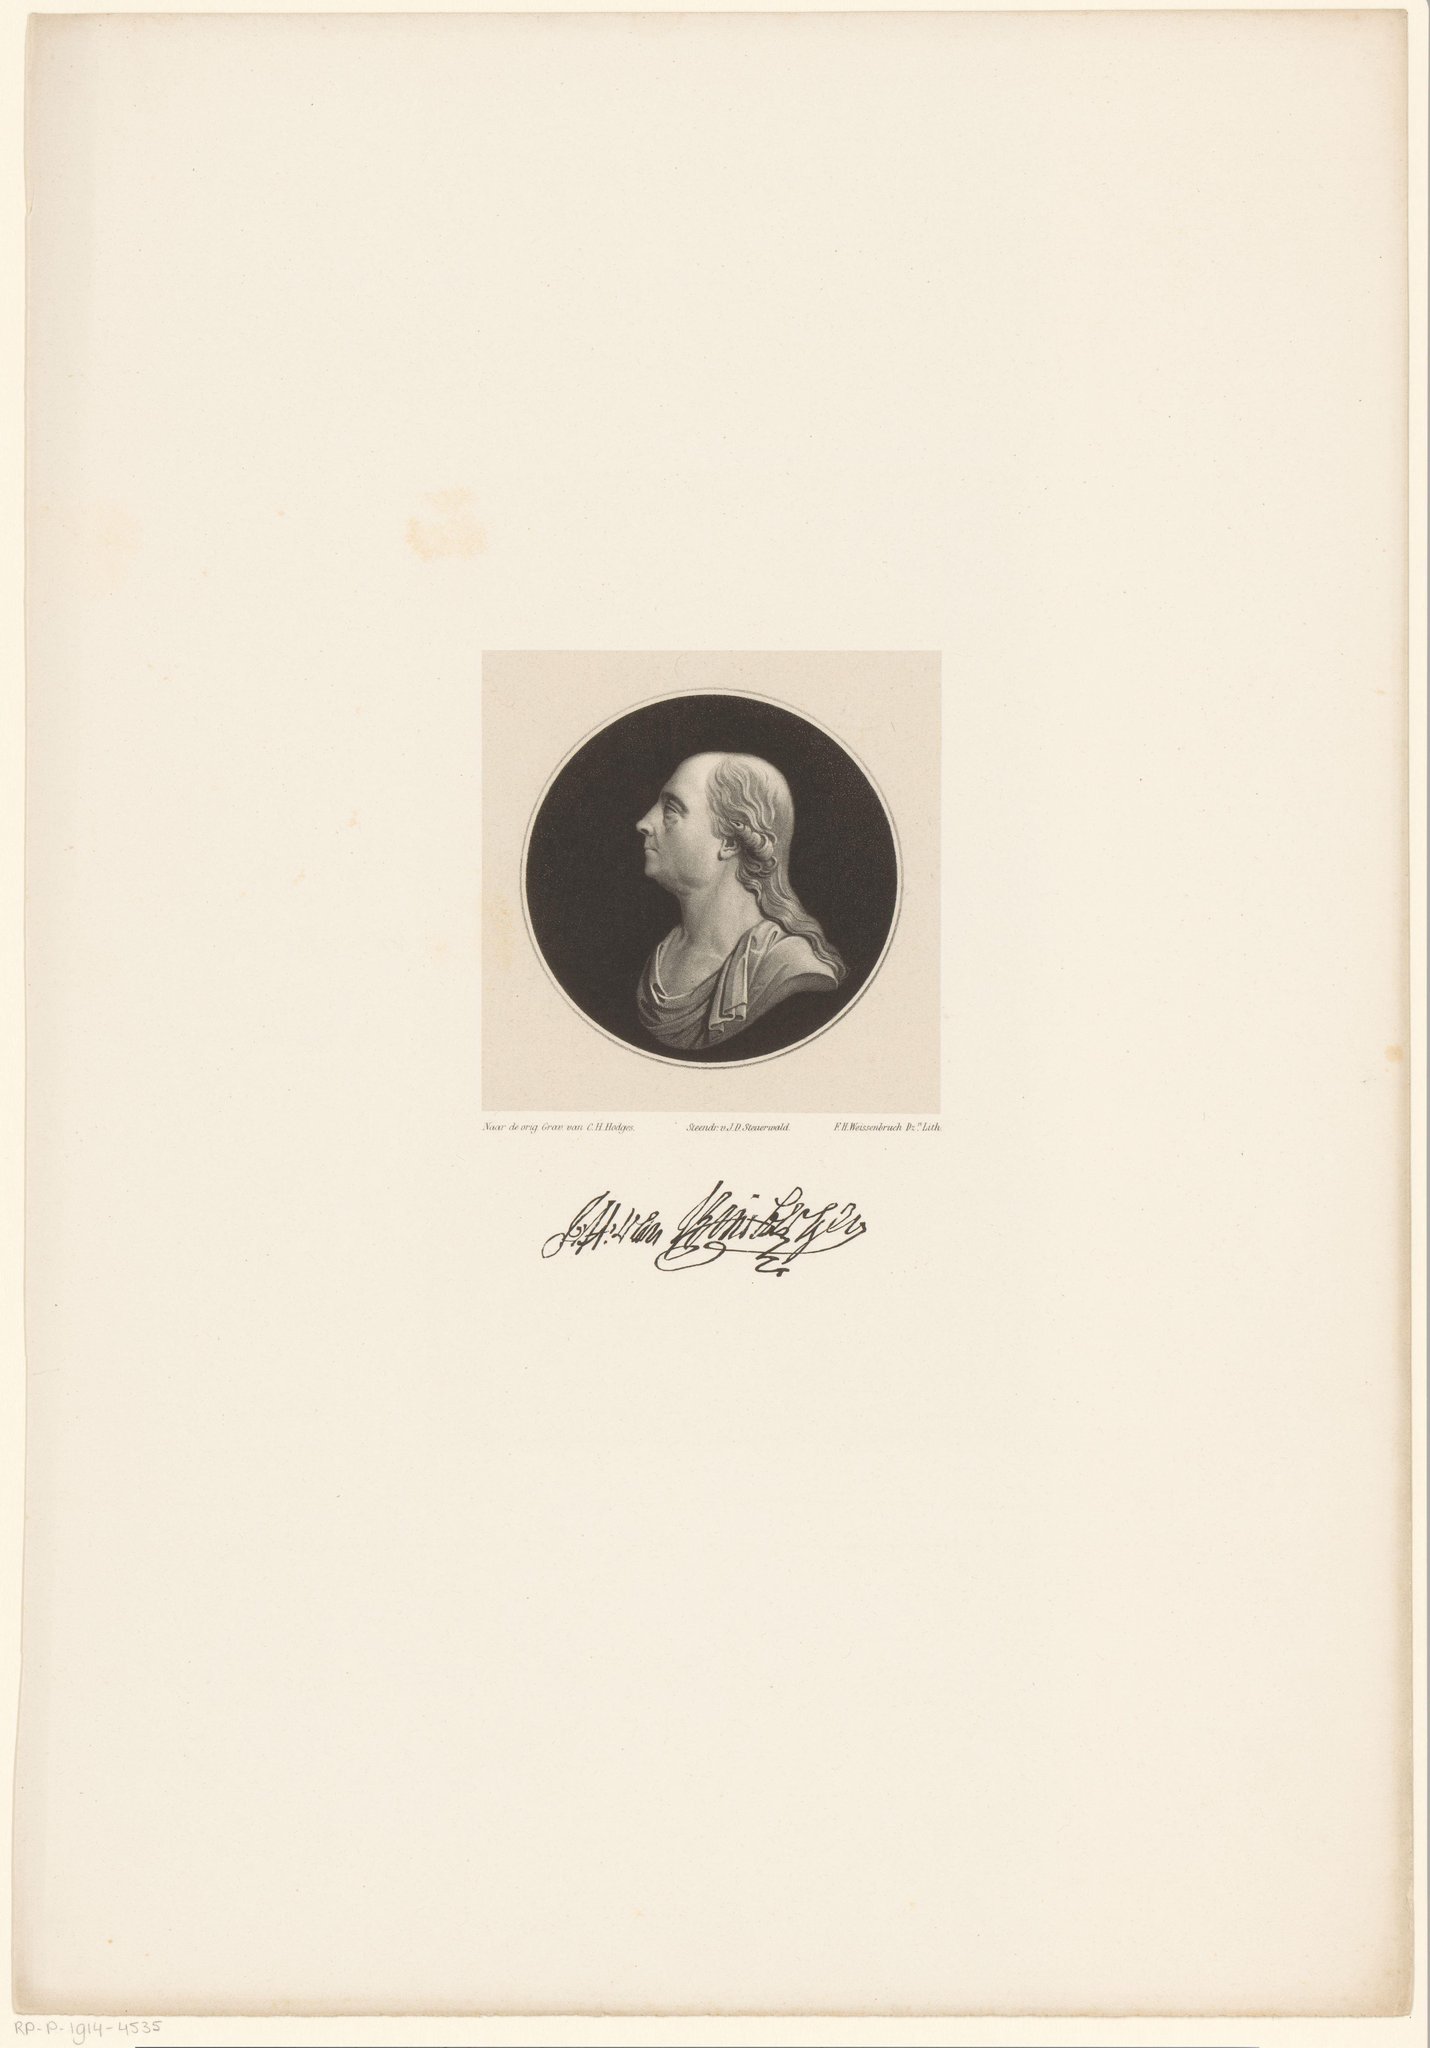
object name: book illustration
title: Profielportret van Jan Hendrik van Kinsbergen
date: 1858-1862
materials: paper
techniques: lithograph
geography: the hague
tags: jonkheer jan hendrik van kinsbergen, historical persons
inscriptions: collector's mark: Lugt 2228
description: Prent uit: Jonge, J.C. de. Geschiedenis van het Nederlandsche zeewezen. Haarlem: Jonge, J.K.J. de, 1858-62.